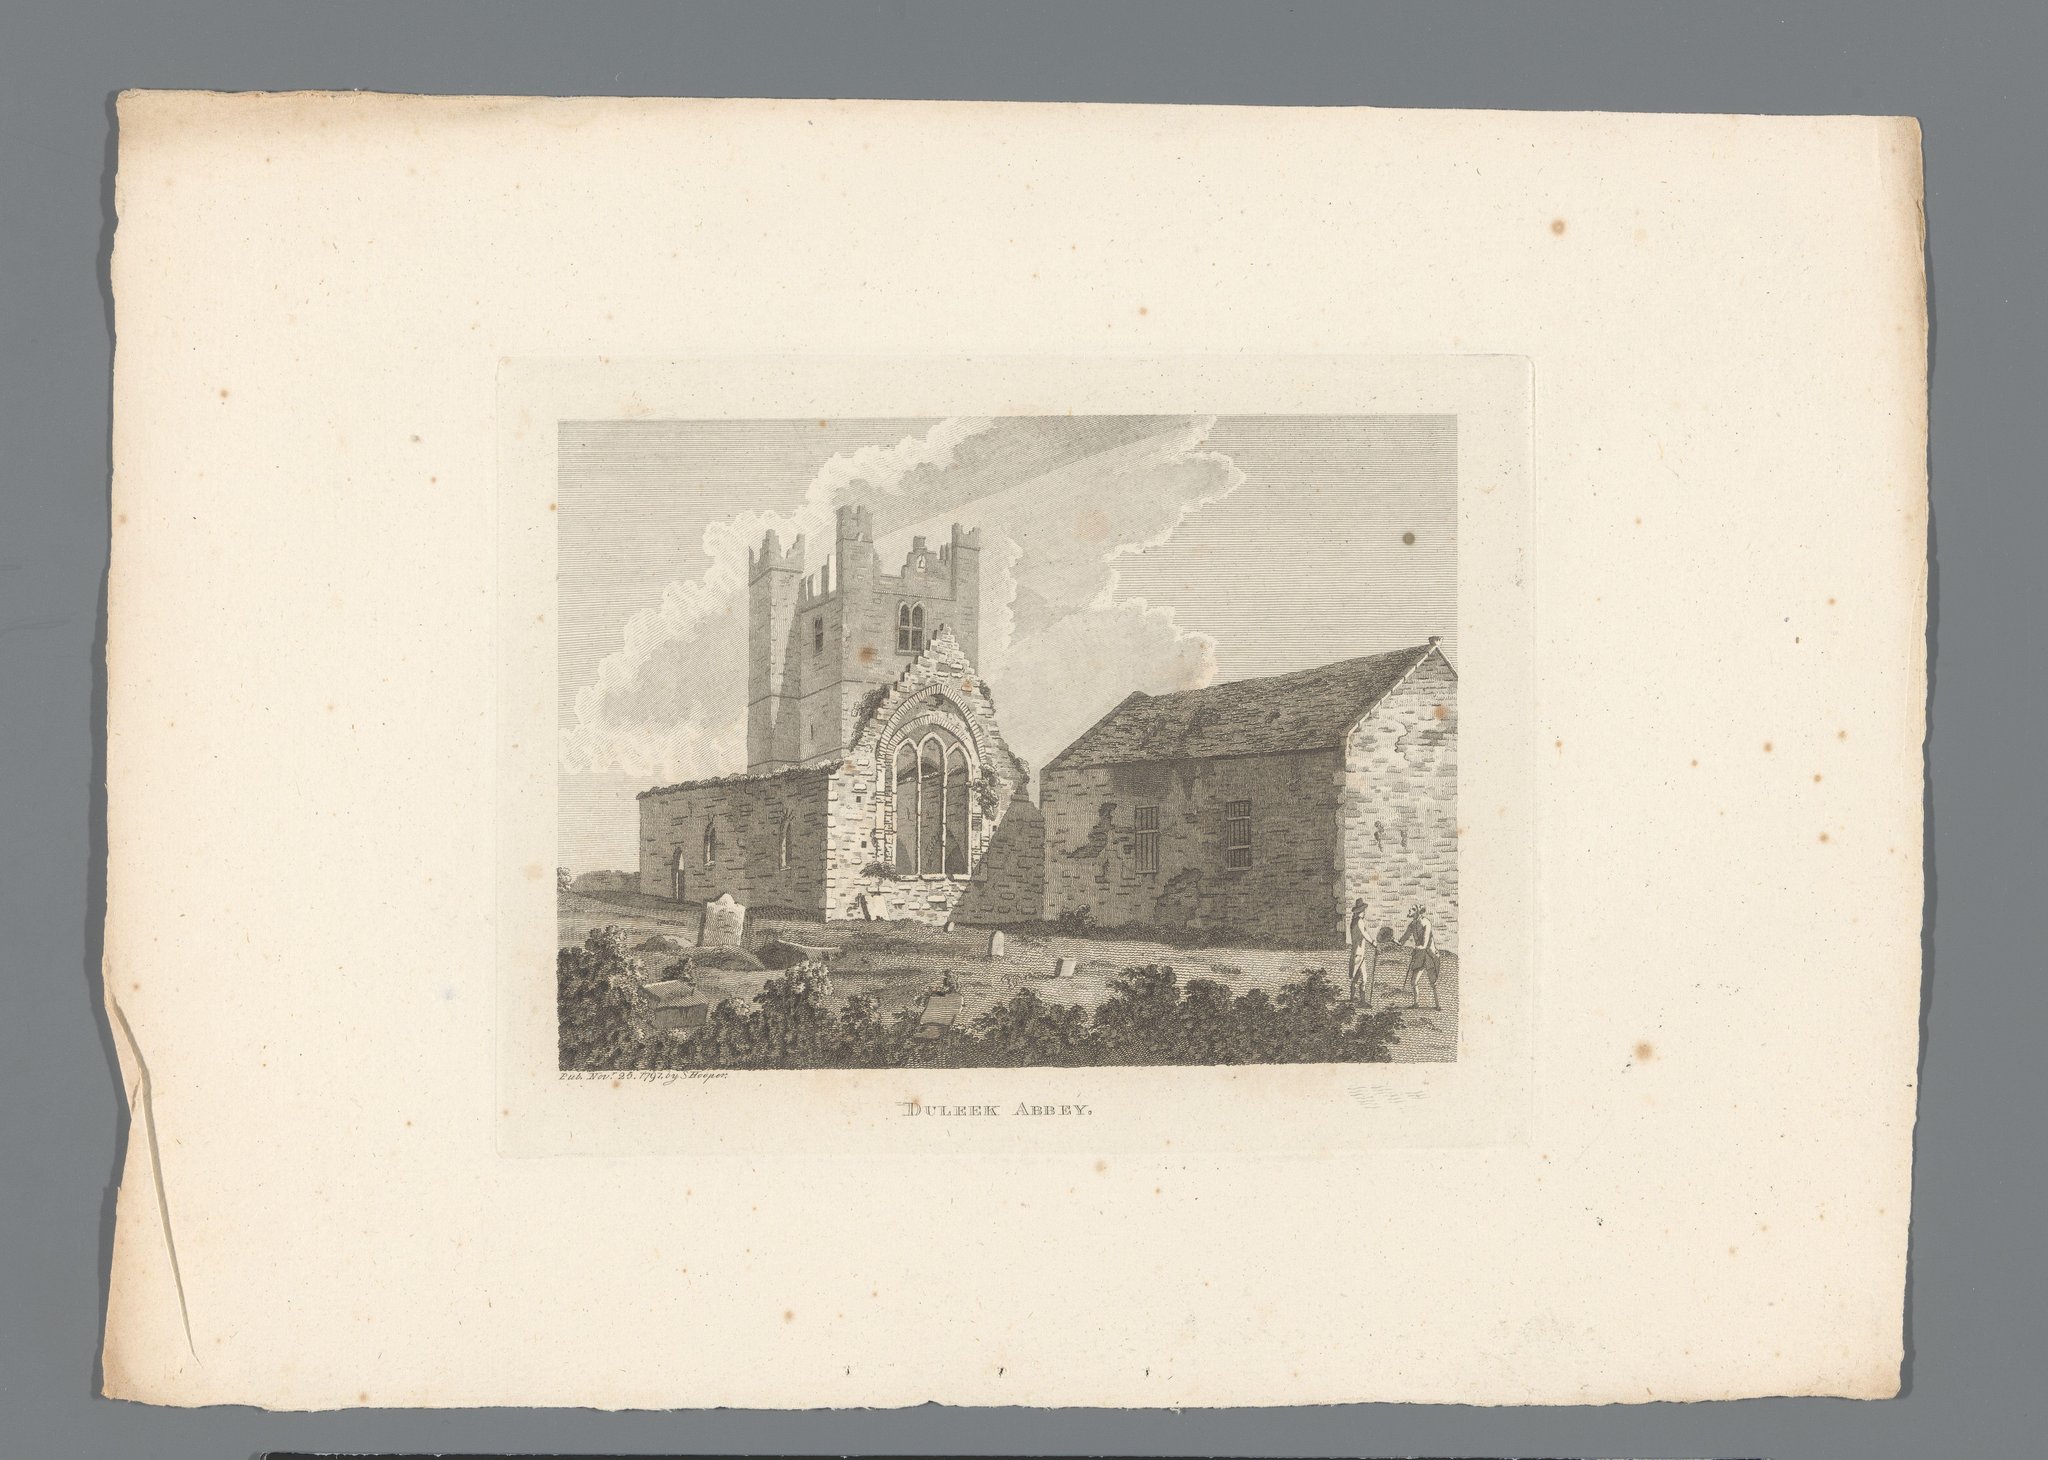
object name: book illustration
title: Plan of Ballintubber Castle. Co.Roscomon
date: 1793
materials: paper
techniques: etching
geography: london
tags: maps, atlases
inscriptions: date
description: Prent verschenen in: Grose, Francis. The antiquities of Ireland. Londen: S. Hooper, 1795, dl. 2.